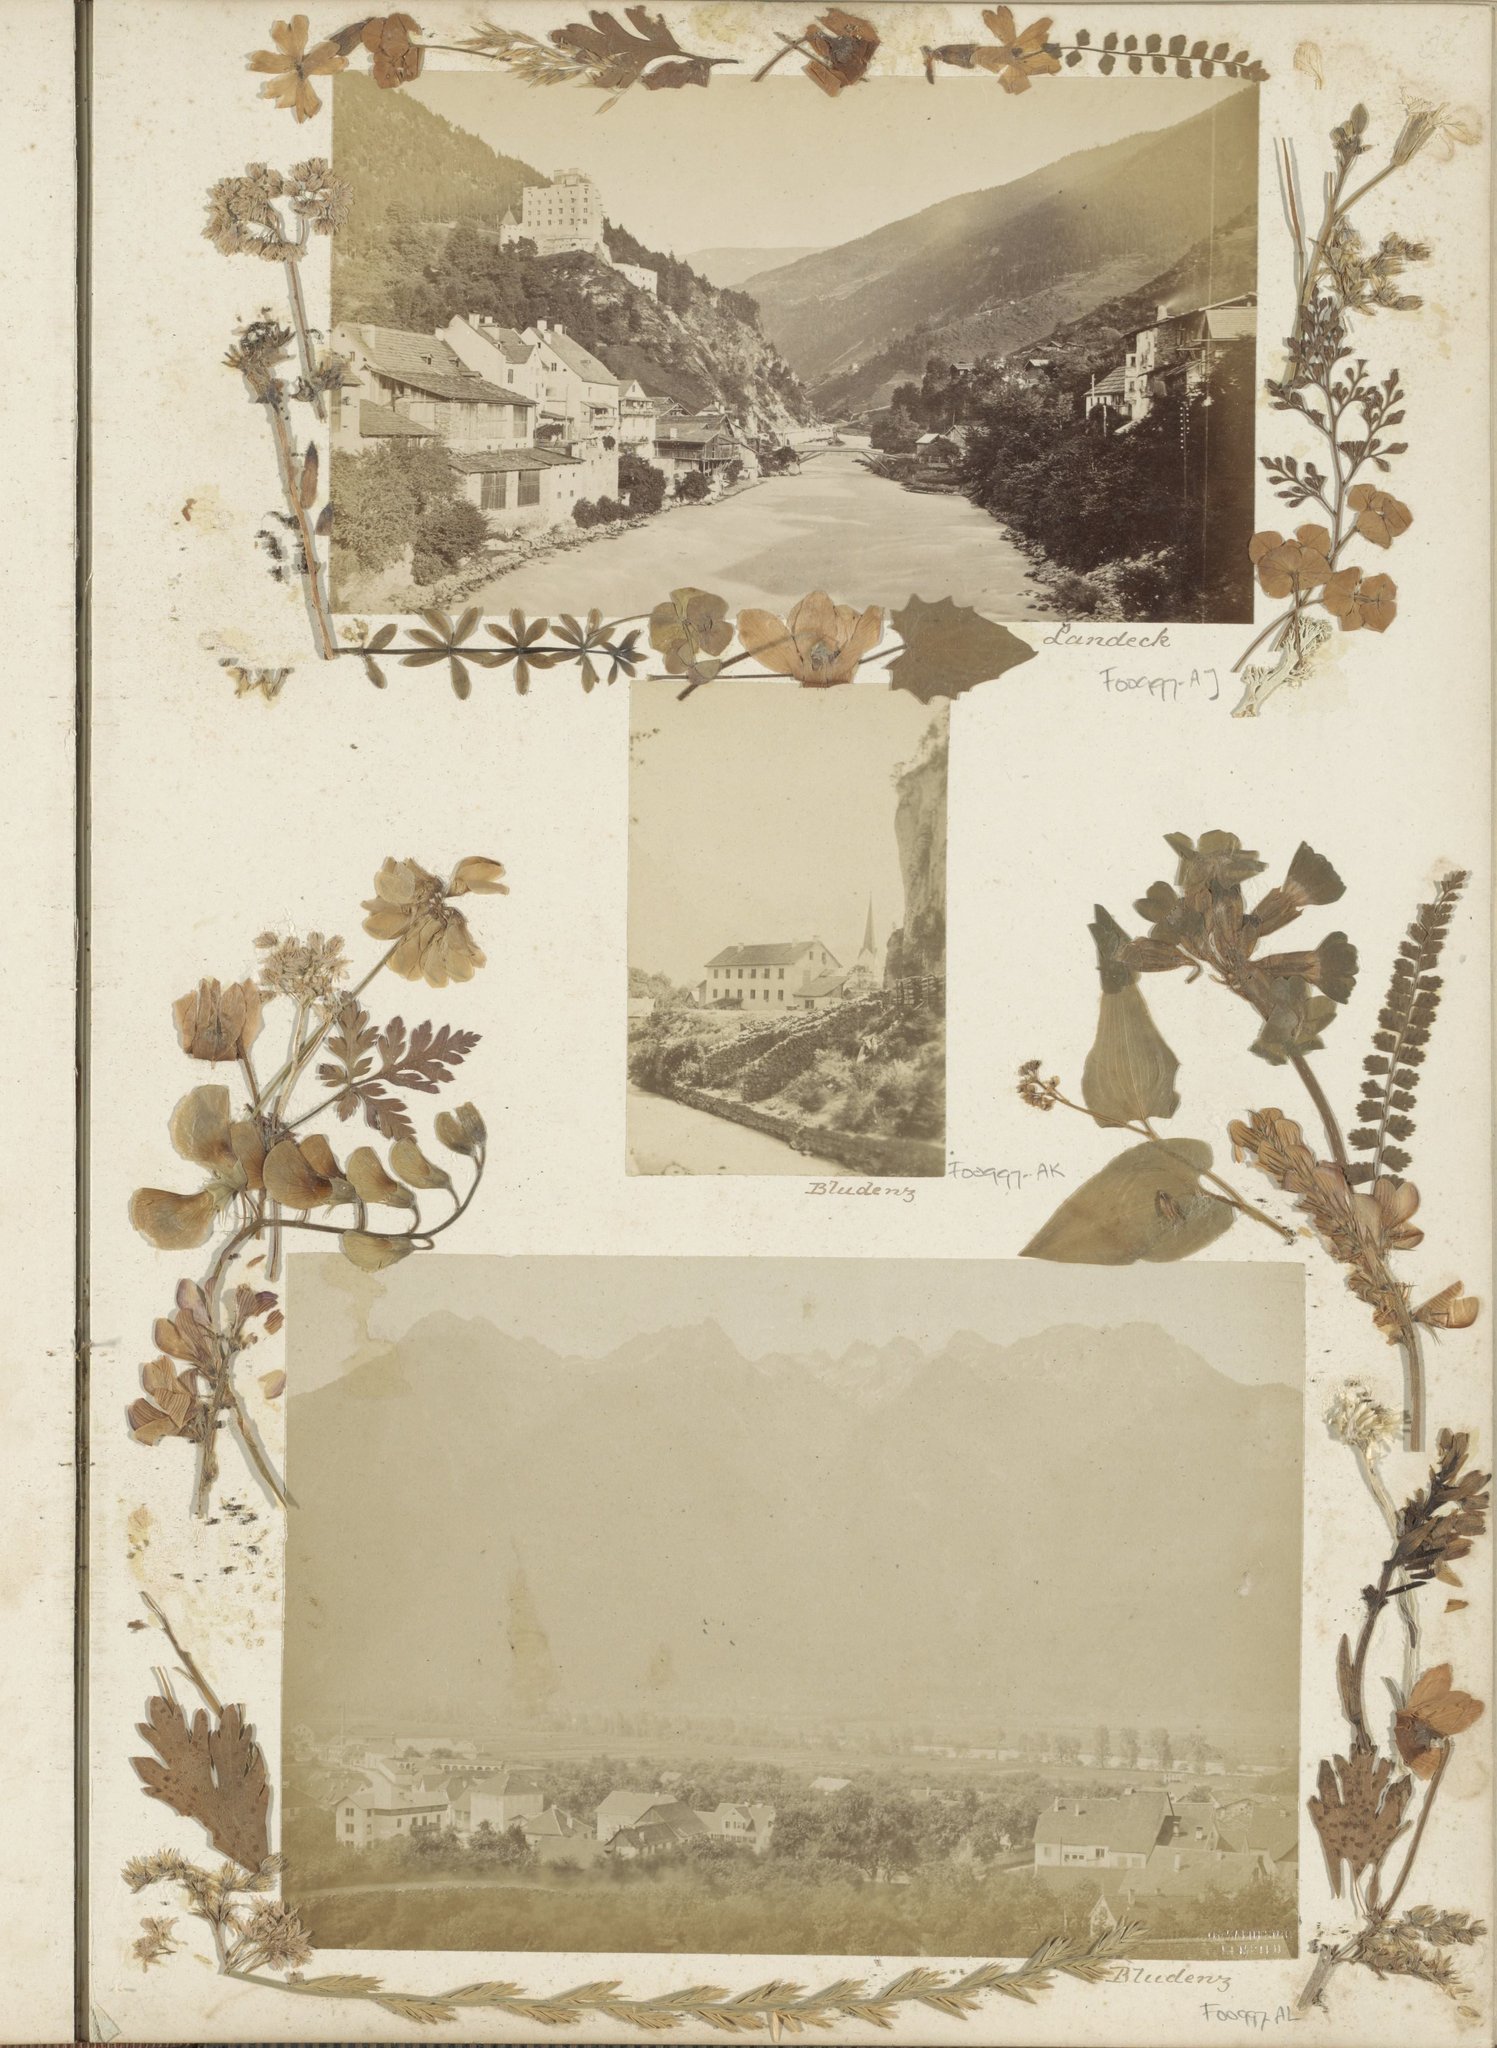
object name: photograph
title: Bludenz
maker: Anonymous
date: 1860-1890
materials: paper, photographic support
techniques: albumen print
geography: bludenz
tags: prospect of village, silhouette of village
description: Onderdeel van Reisalbum met foto's van Zwitserland, Oostenrijk, Italië en Duitsland.